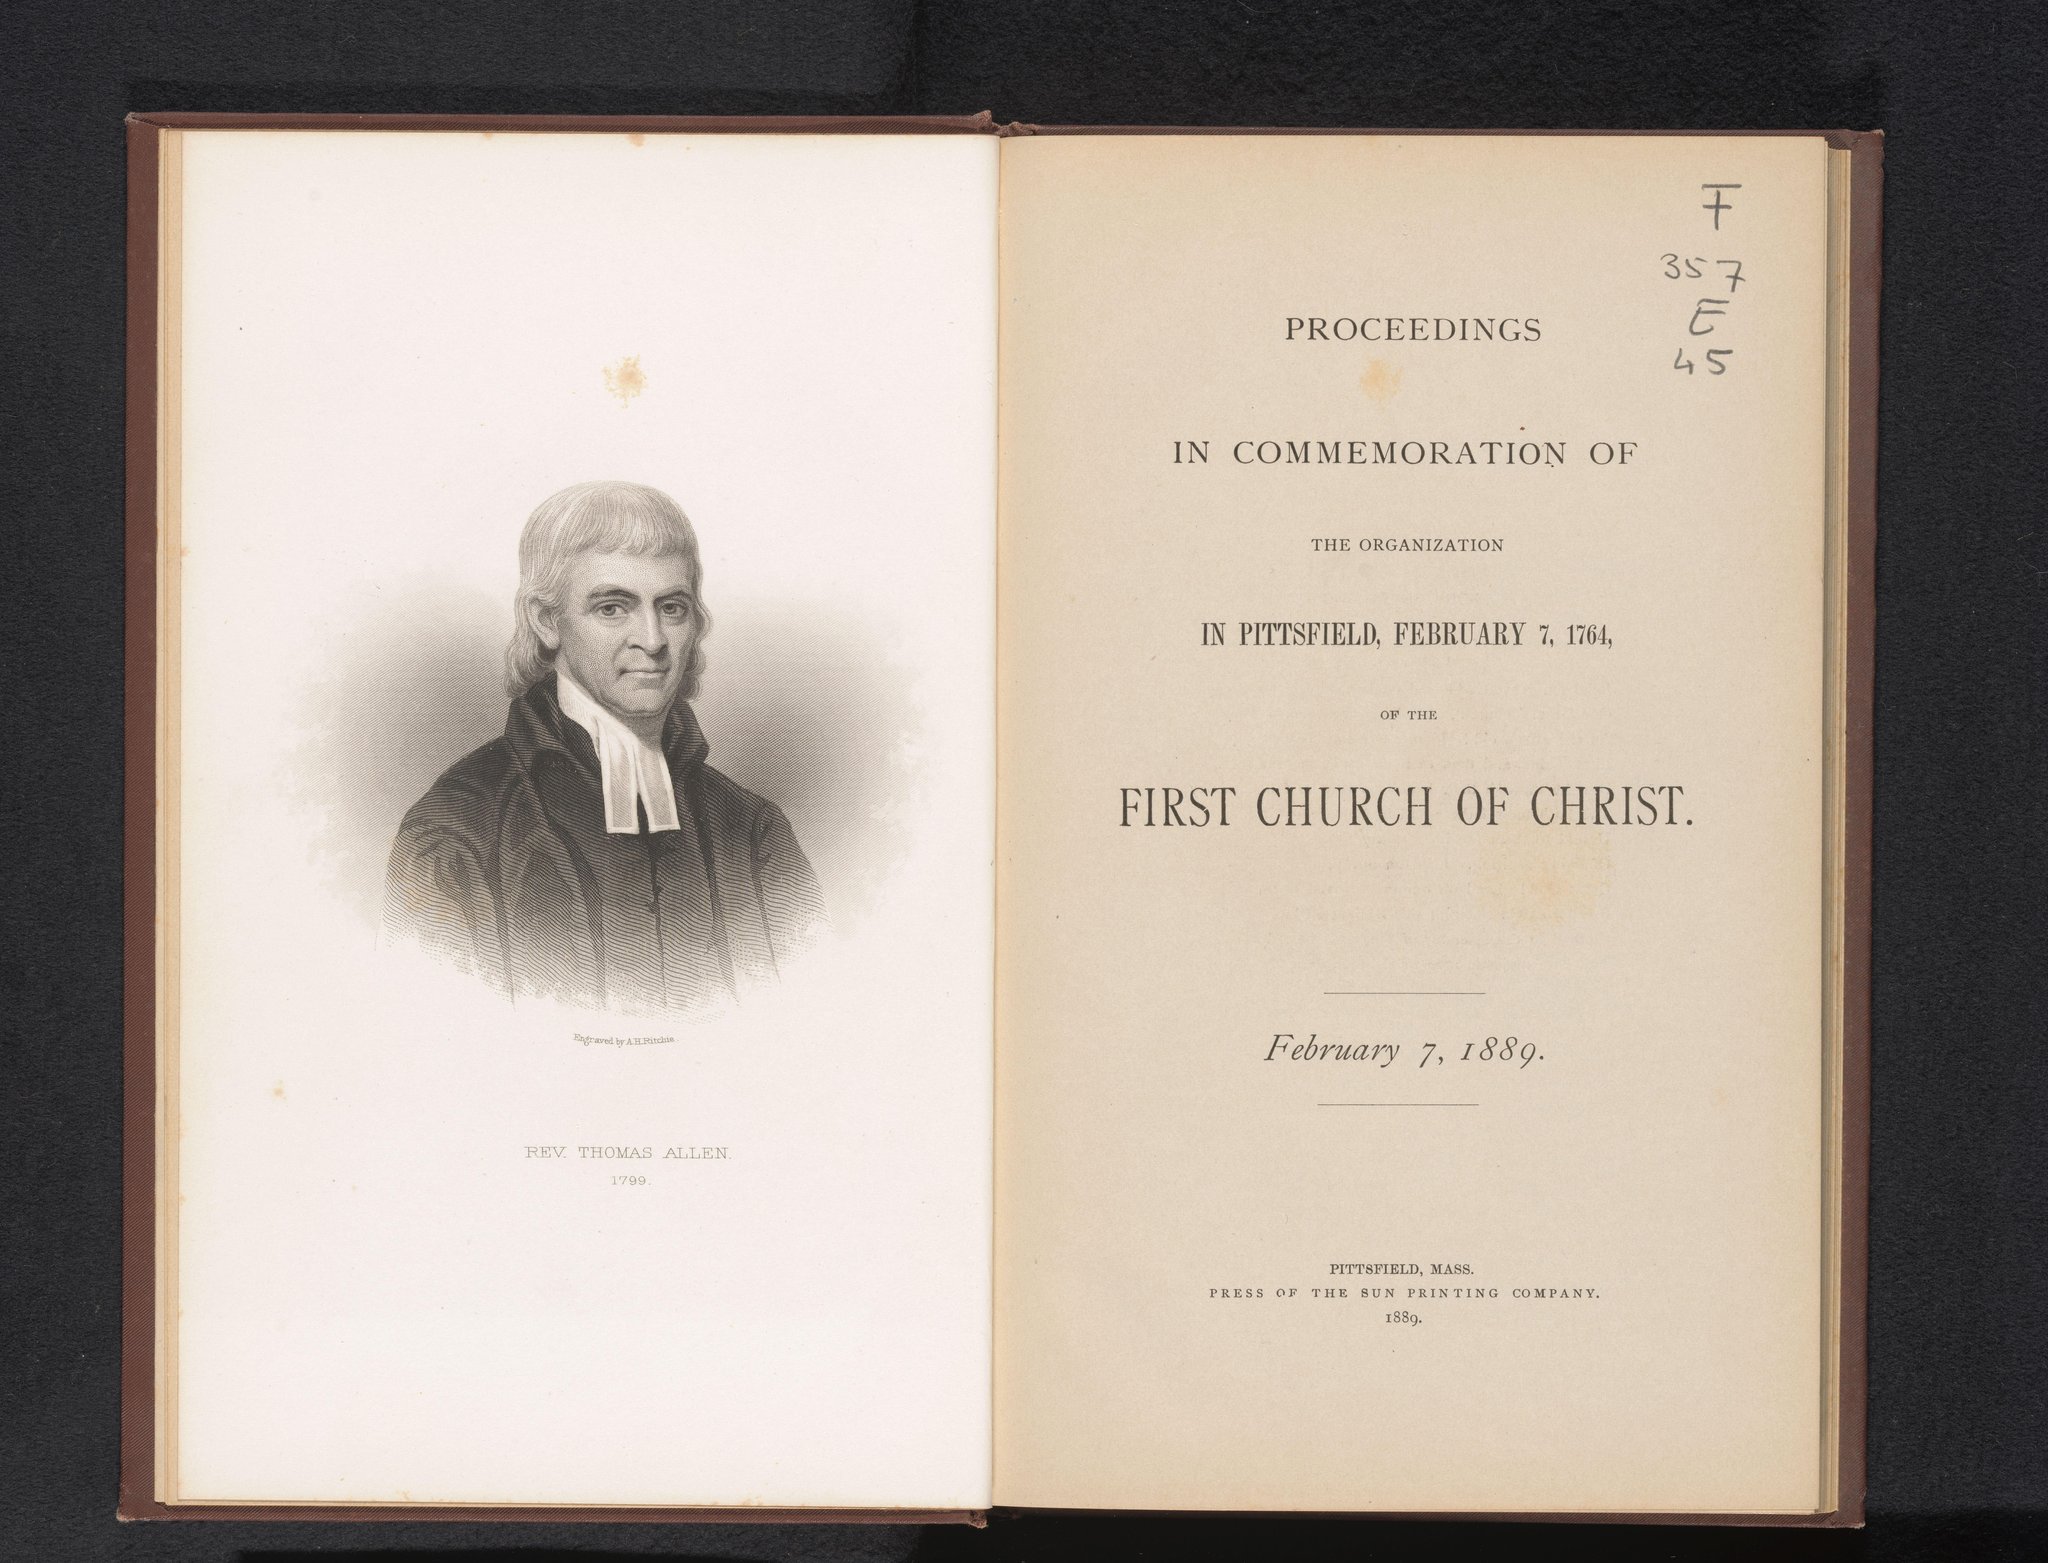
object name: book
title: Proceedings in commemoration of the organization in Pittsfield, February 7, 1864 of the First Church of Christ : February 7, 1889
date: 1889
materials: cardboard, linen, paper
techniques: photoaquatint, printing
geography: pittsfield